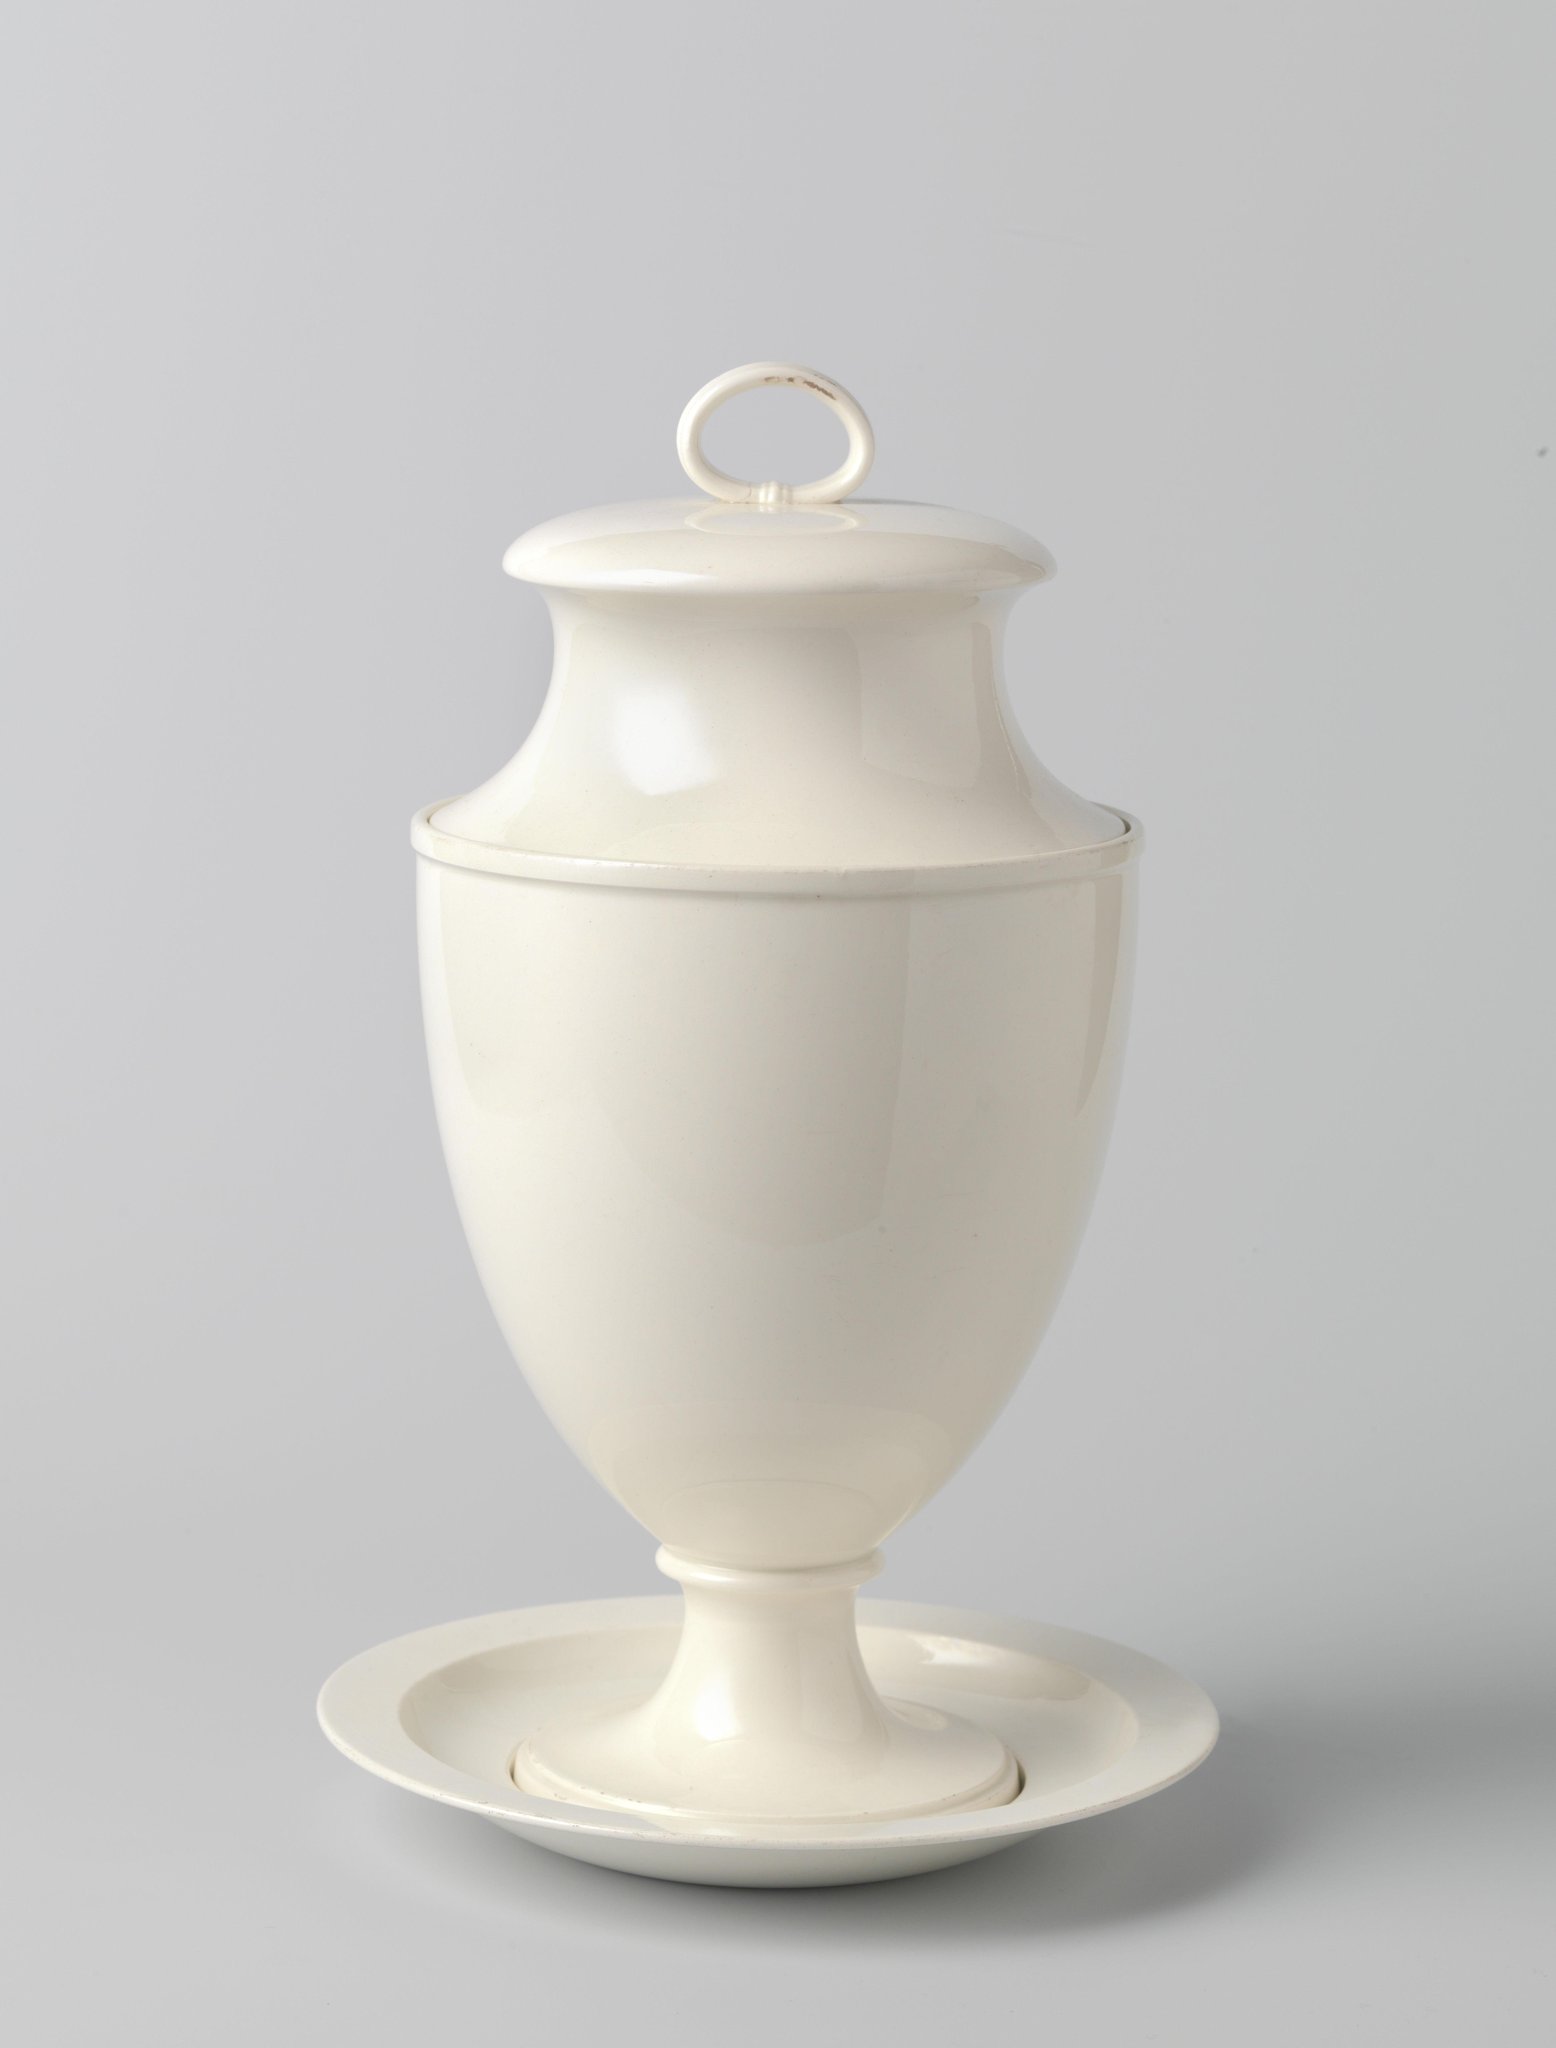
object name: vase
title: Vaas van hardgebakken aardewerk, Wedgwood creamware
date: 1800-1830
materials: earthenware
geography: england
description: Convex trechtervormige vaas, op een gewelfde voet van hardgebakken aardewerk. De vaas is gemerkt: Wedgwood.